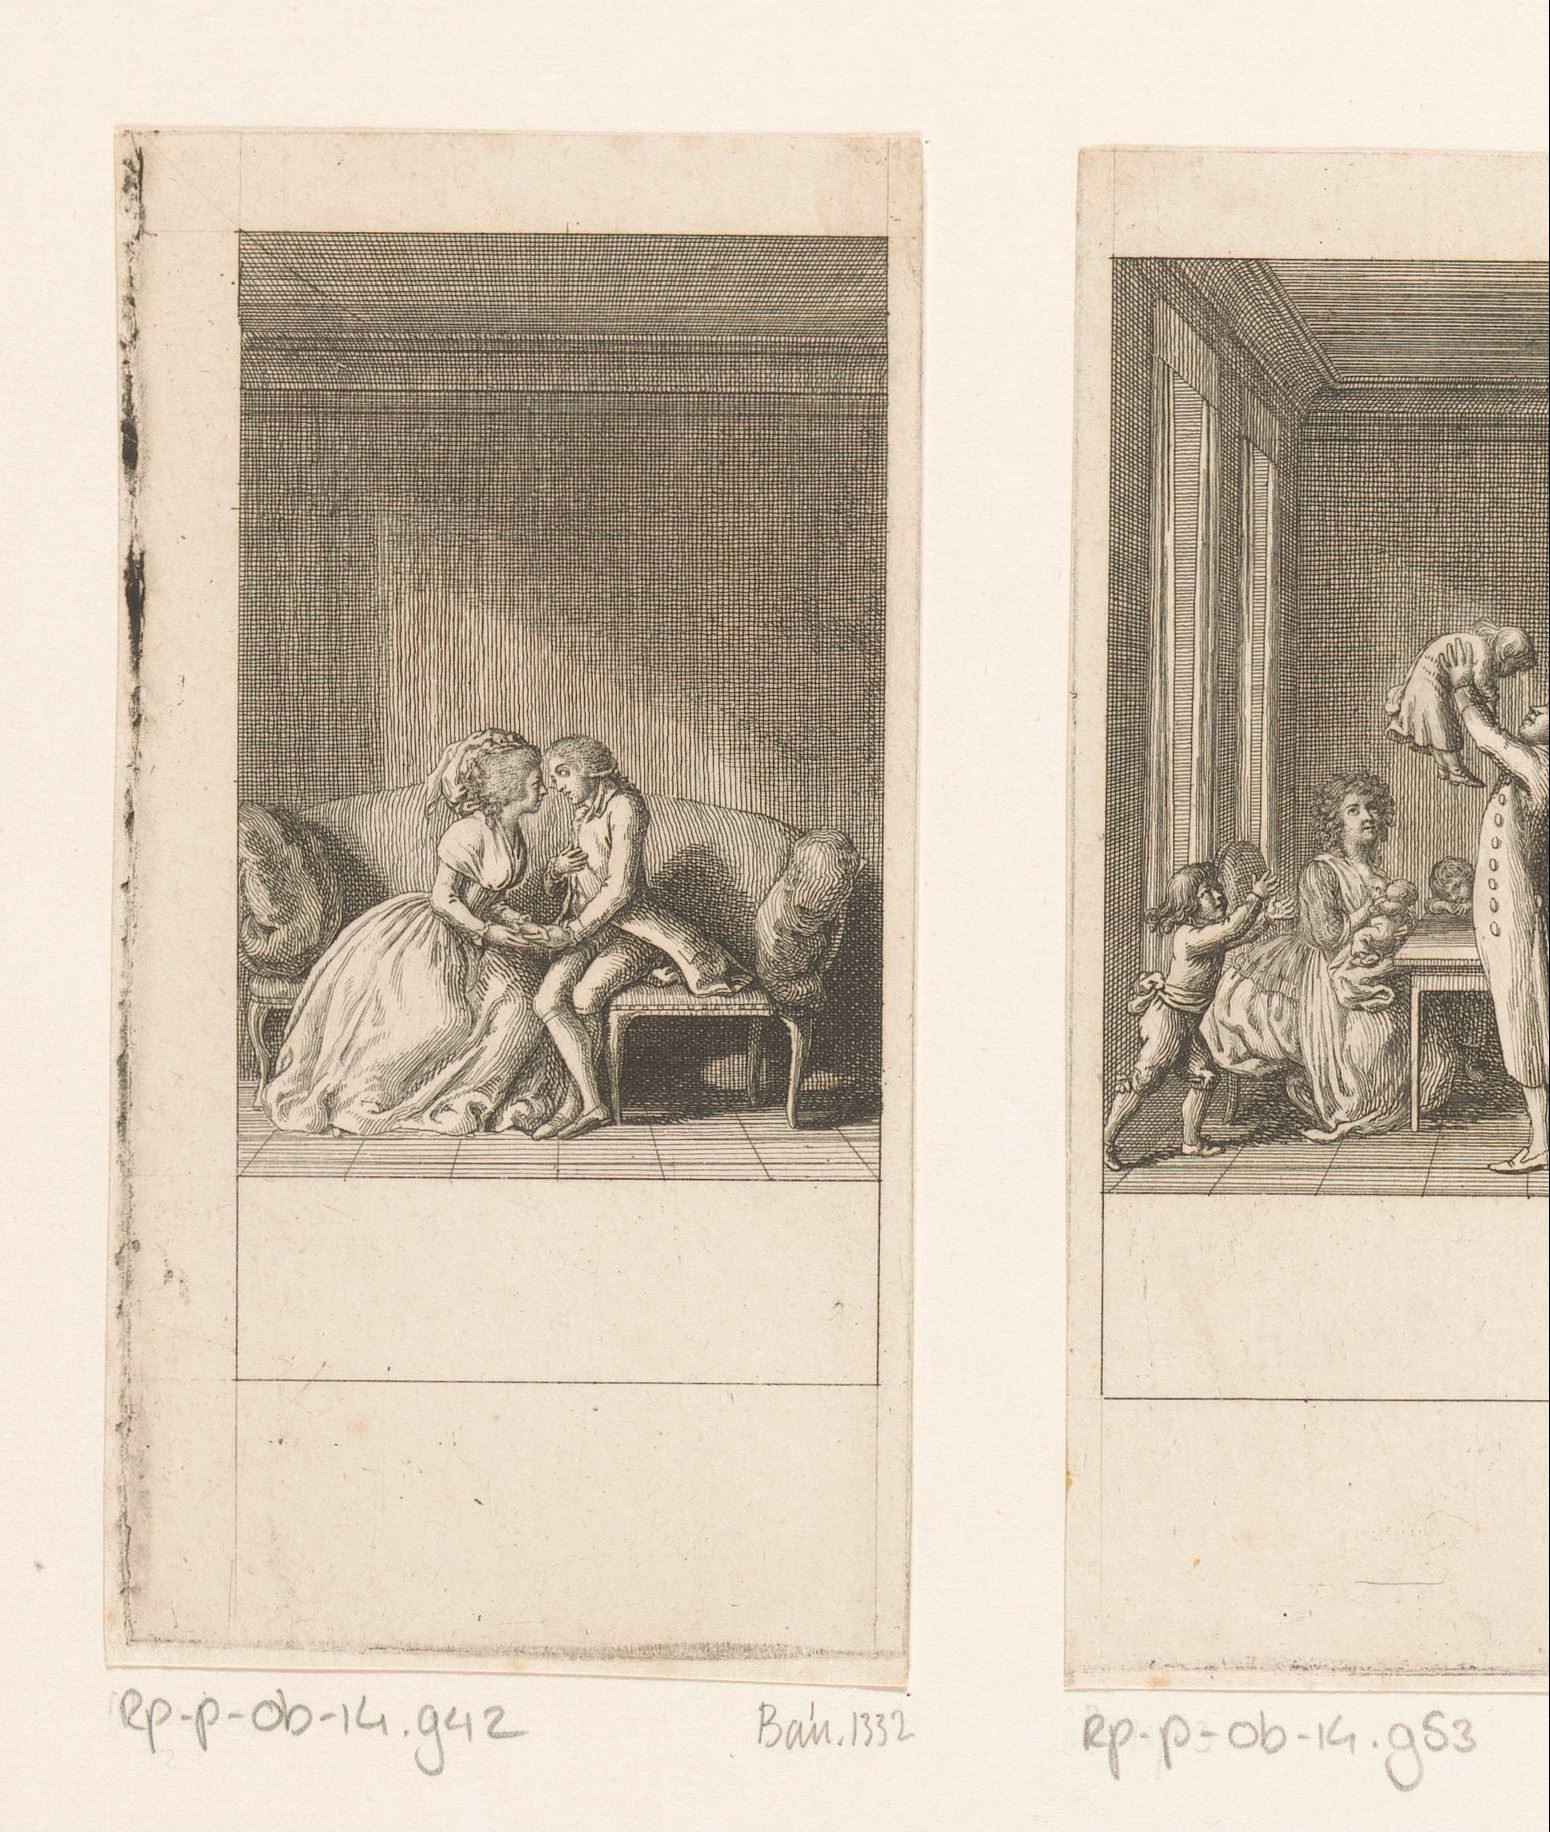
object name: print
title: Huwelijk door liefde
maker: daniel nikolaus chodowiecki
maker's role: draughtsman, print maker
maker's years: 1726-1801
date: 1788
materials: paper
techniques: etching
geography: berlin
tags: betrothal and marriage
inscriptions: collector's mark: Lugt 2228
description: Latere staat gebruikt voor: Goettinger Taschen Calender vom Jahr 1789. [Göttingen]: Johann Christoph Dietrich, [1788].